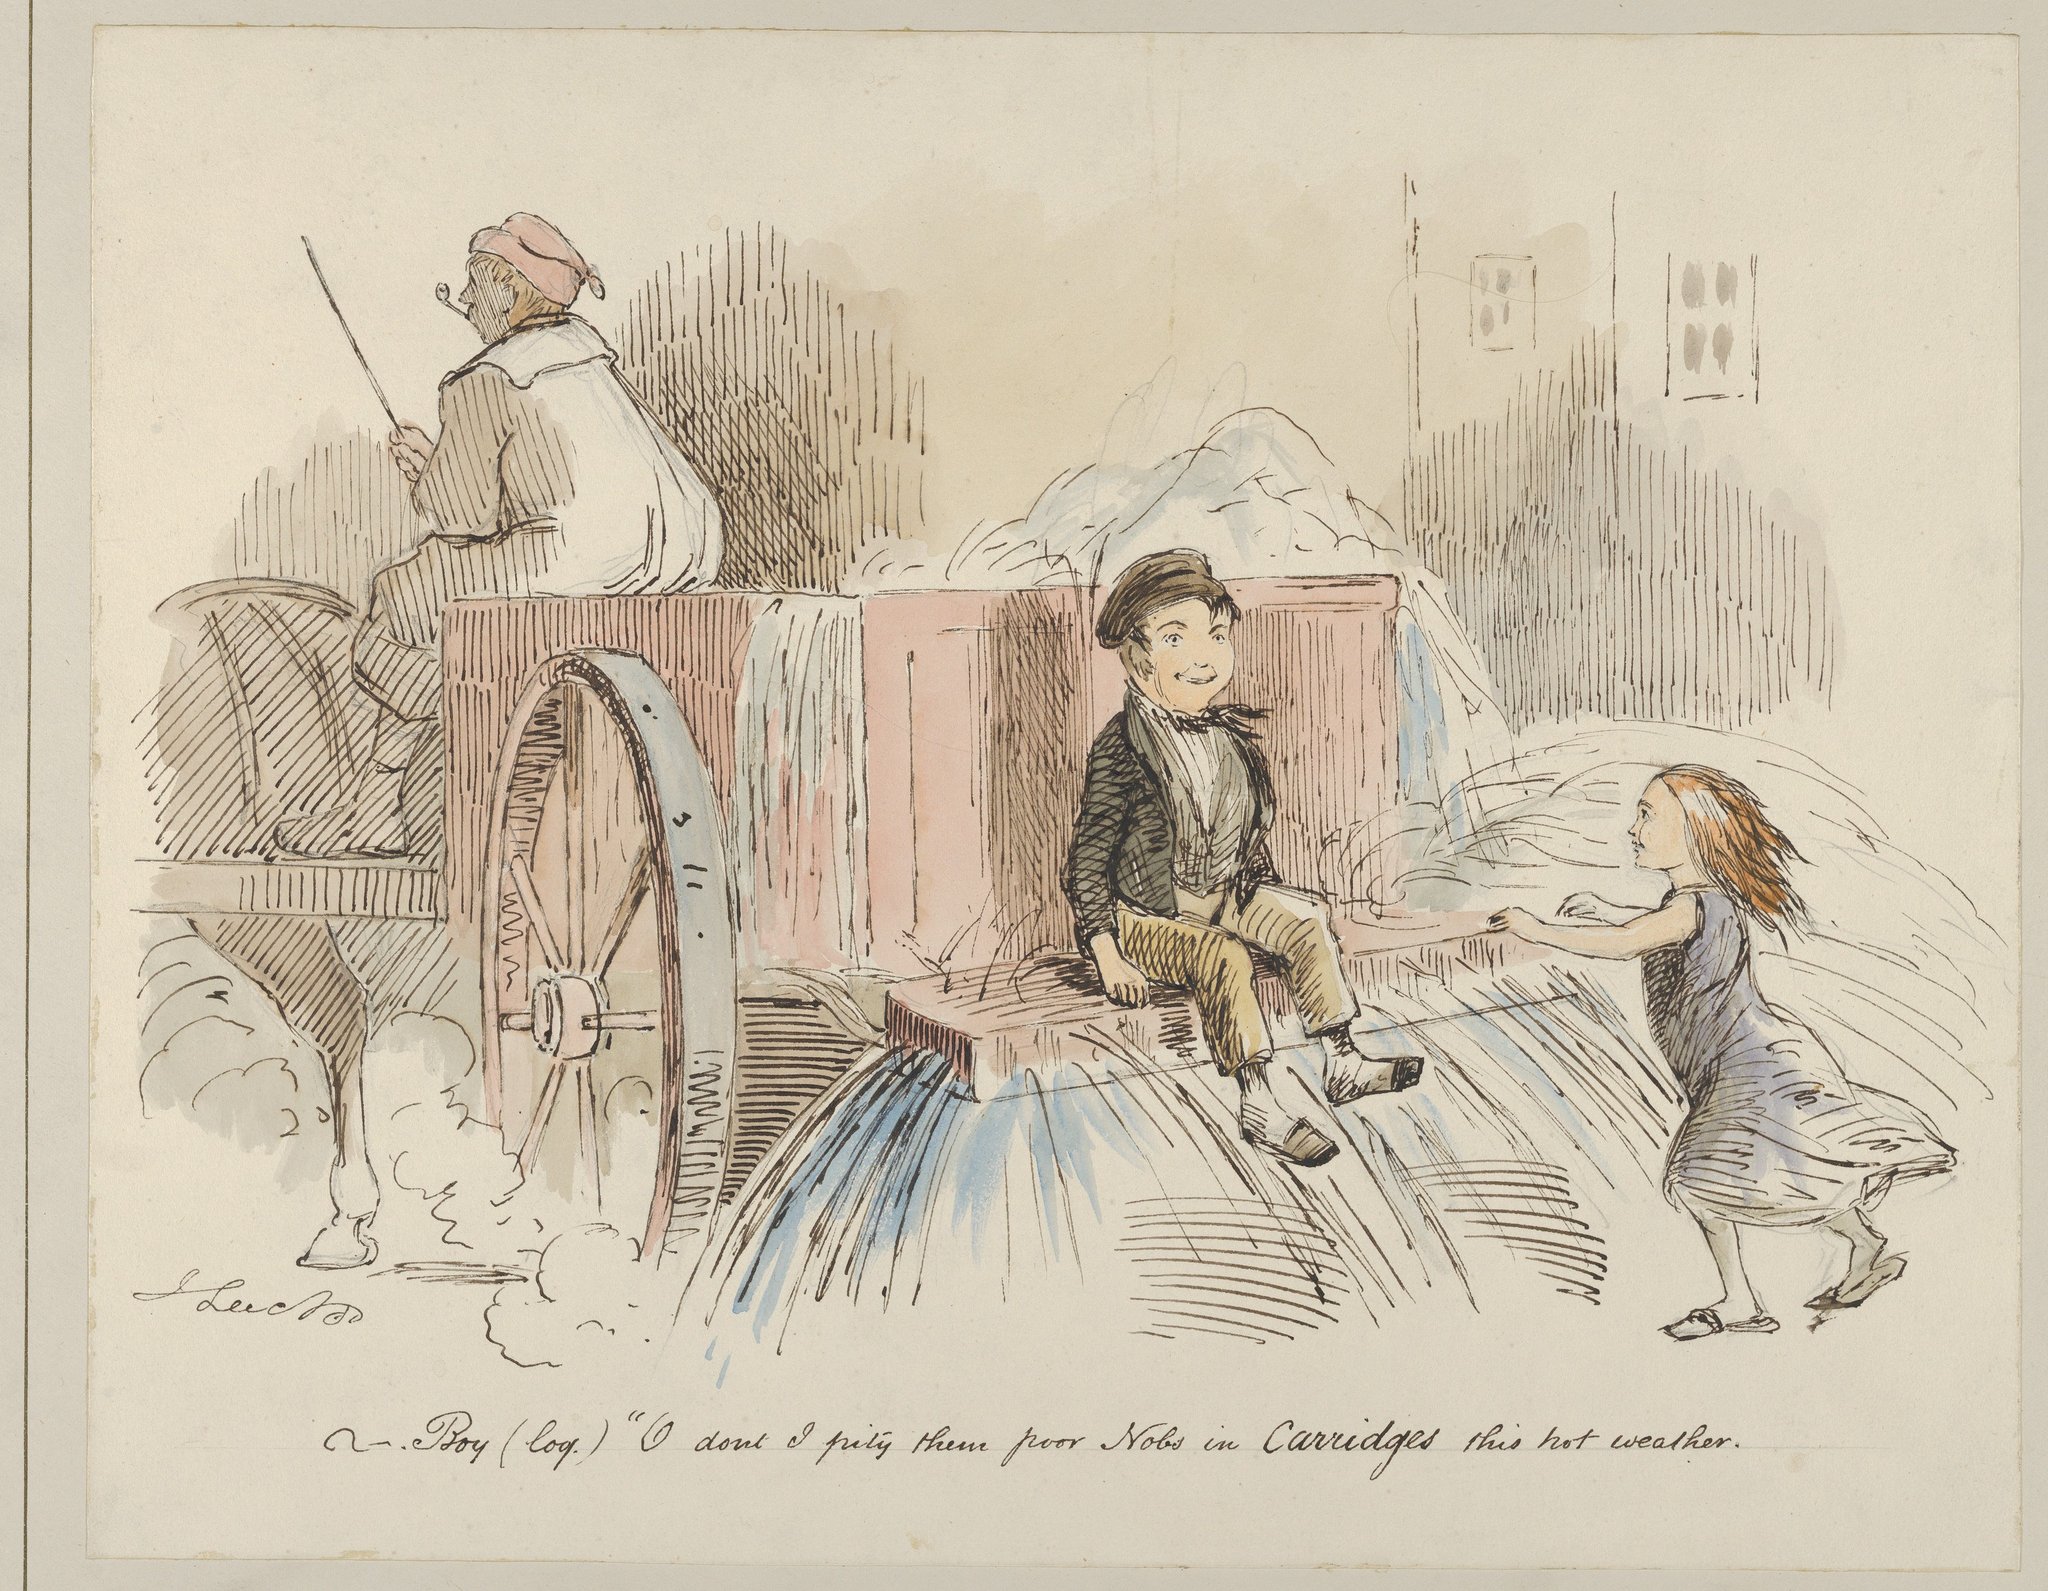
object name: drawing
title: Boy (loq.) O don't I pity them poor Nobs in Carriages this hot weather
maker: john leech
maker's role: artist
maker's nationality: british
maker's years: 1817-1864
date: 1830-1864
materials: ink, watercolor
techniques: pen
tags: boys,girls,men,smoking,carriages